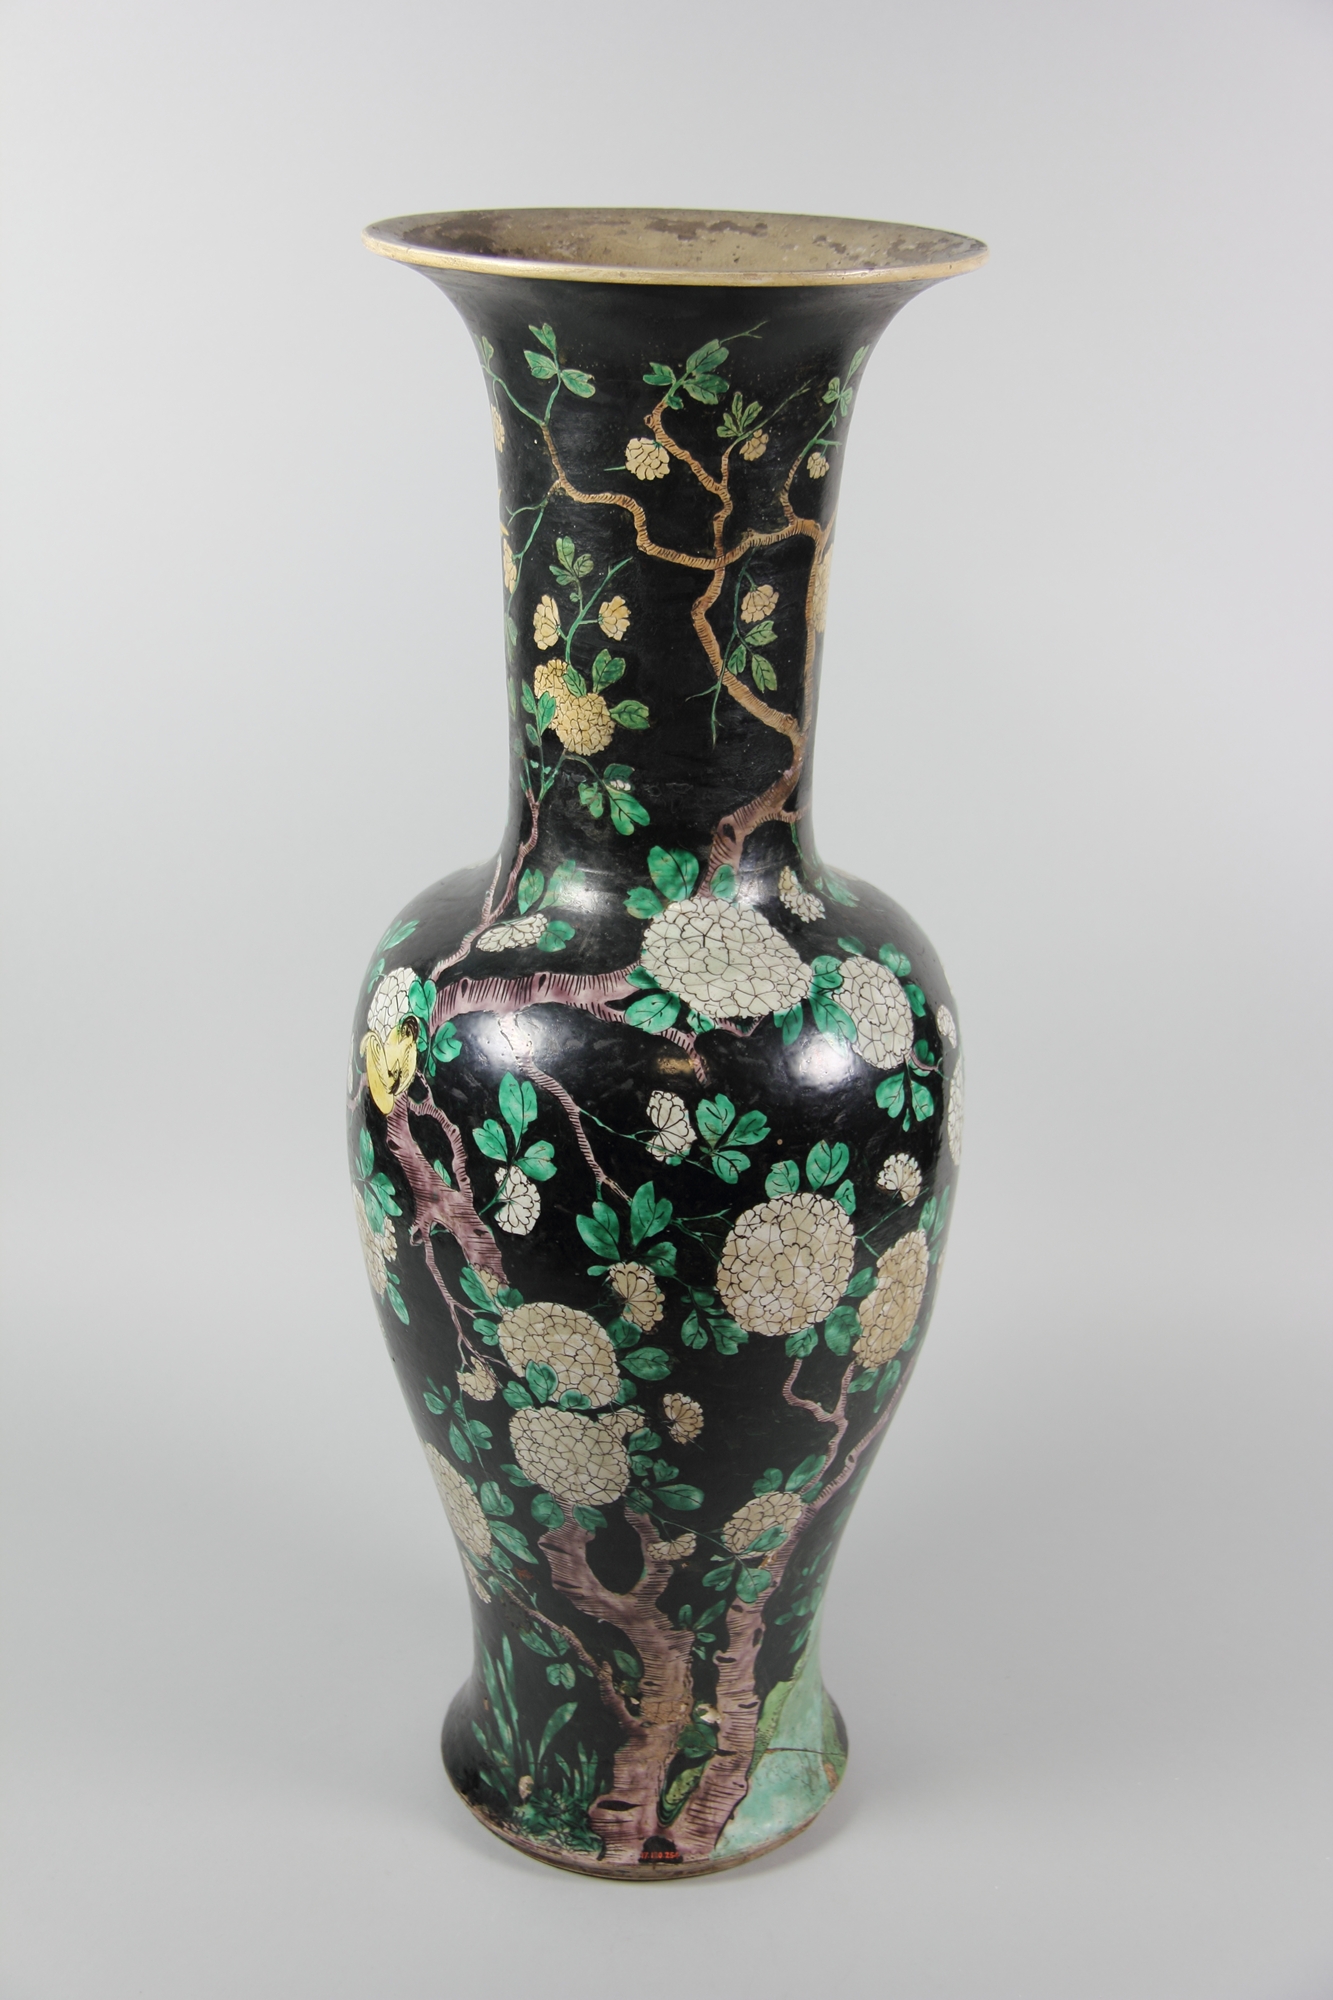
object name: vase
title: Vase with birds and flowers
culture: chinese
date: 1801-1900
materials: enamel, porcelain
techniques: painting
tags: flowers,leaves,trees